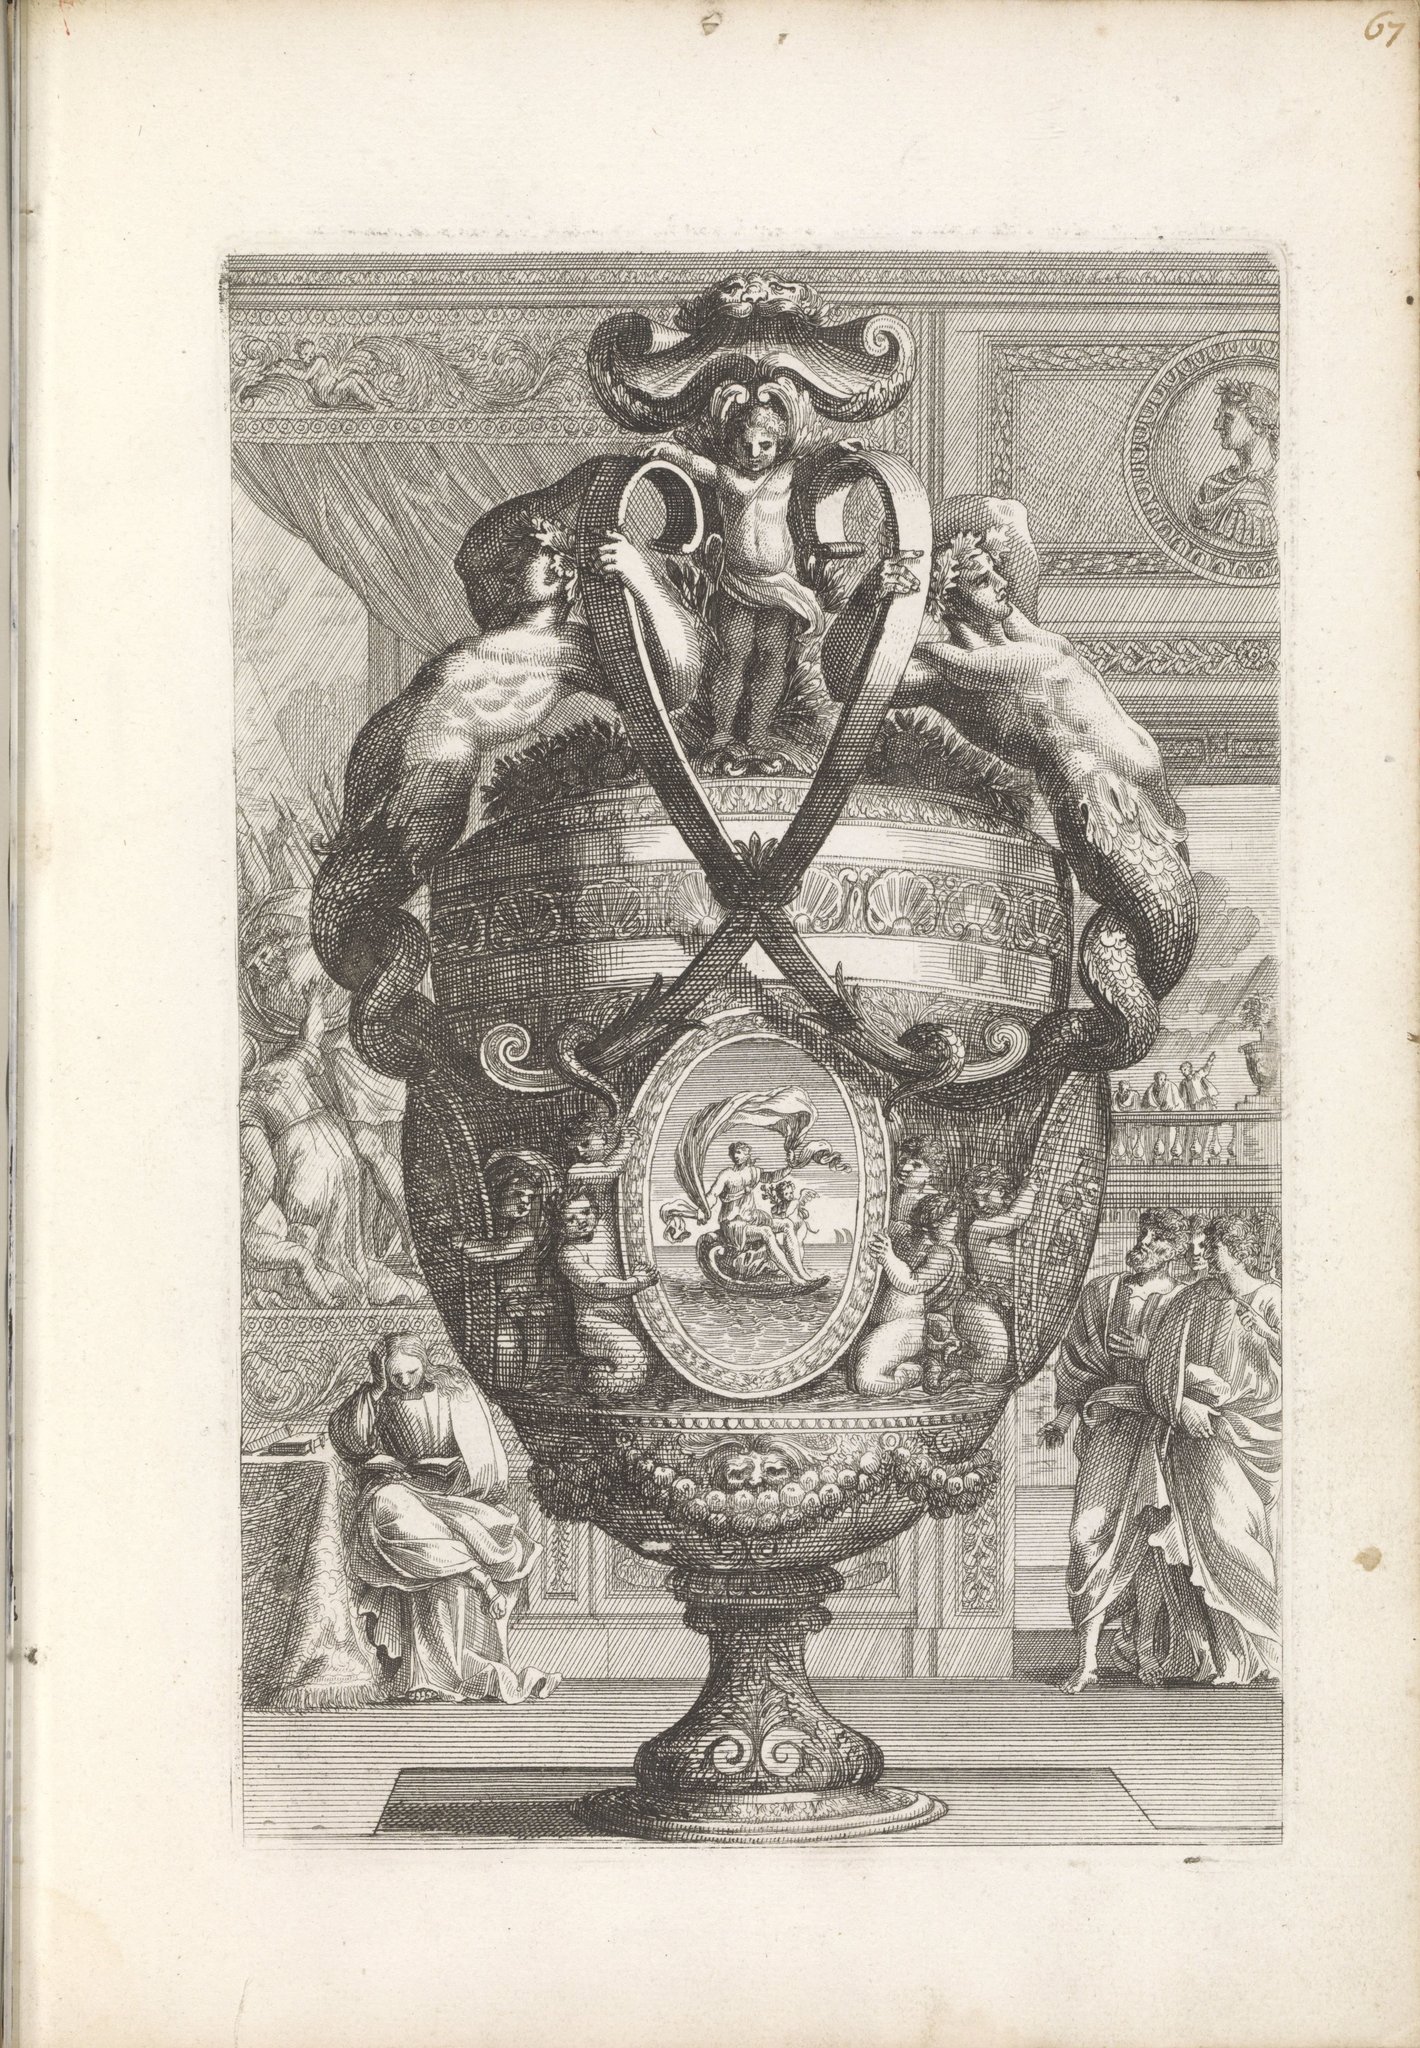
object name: ornament print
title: Vasi fatti al moderno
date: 1659-1678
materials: paper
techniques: etching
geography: paris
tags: ornaments ~ art, dragon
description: De vaas heeft handvatten in de vorm van tritons, onder de tuit staat een putto. Kopie naar een prent in de serie Vases à la moderne. Prent maakt deel uit van een album.